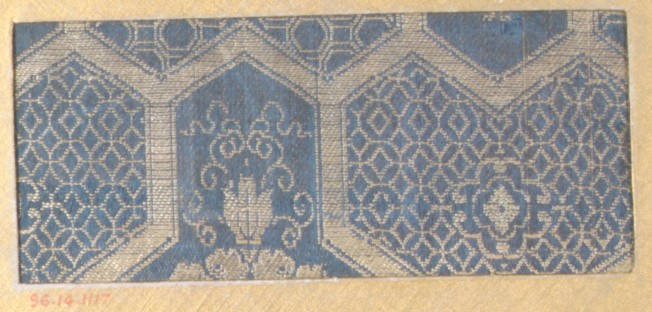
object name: piece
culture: japanese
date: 1701-1900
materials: silk